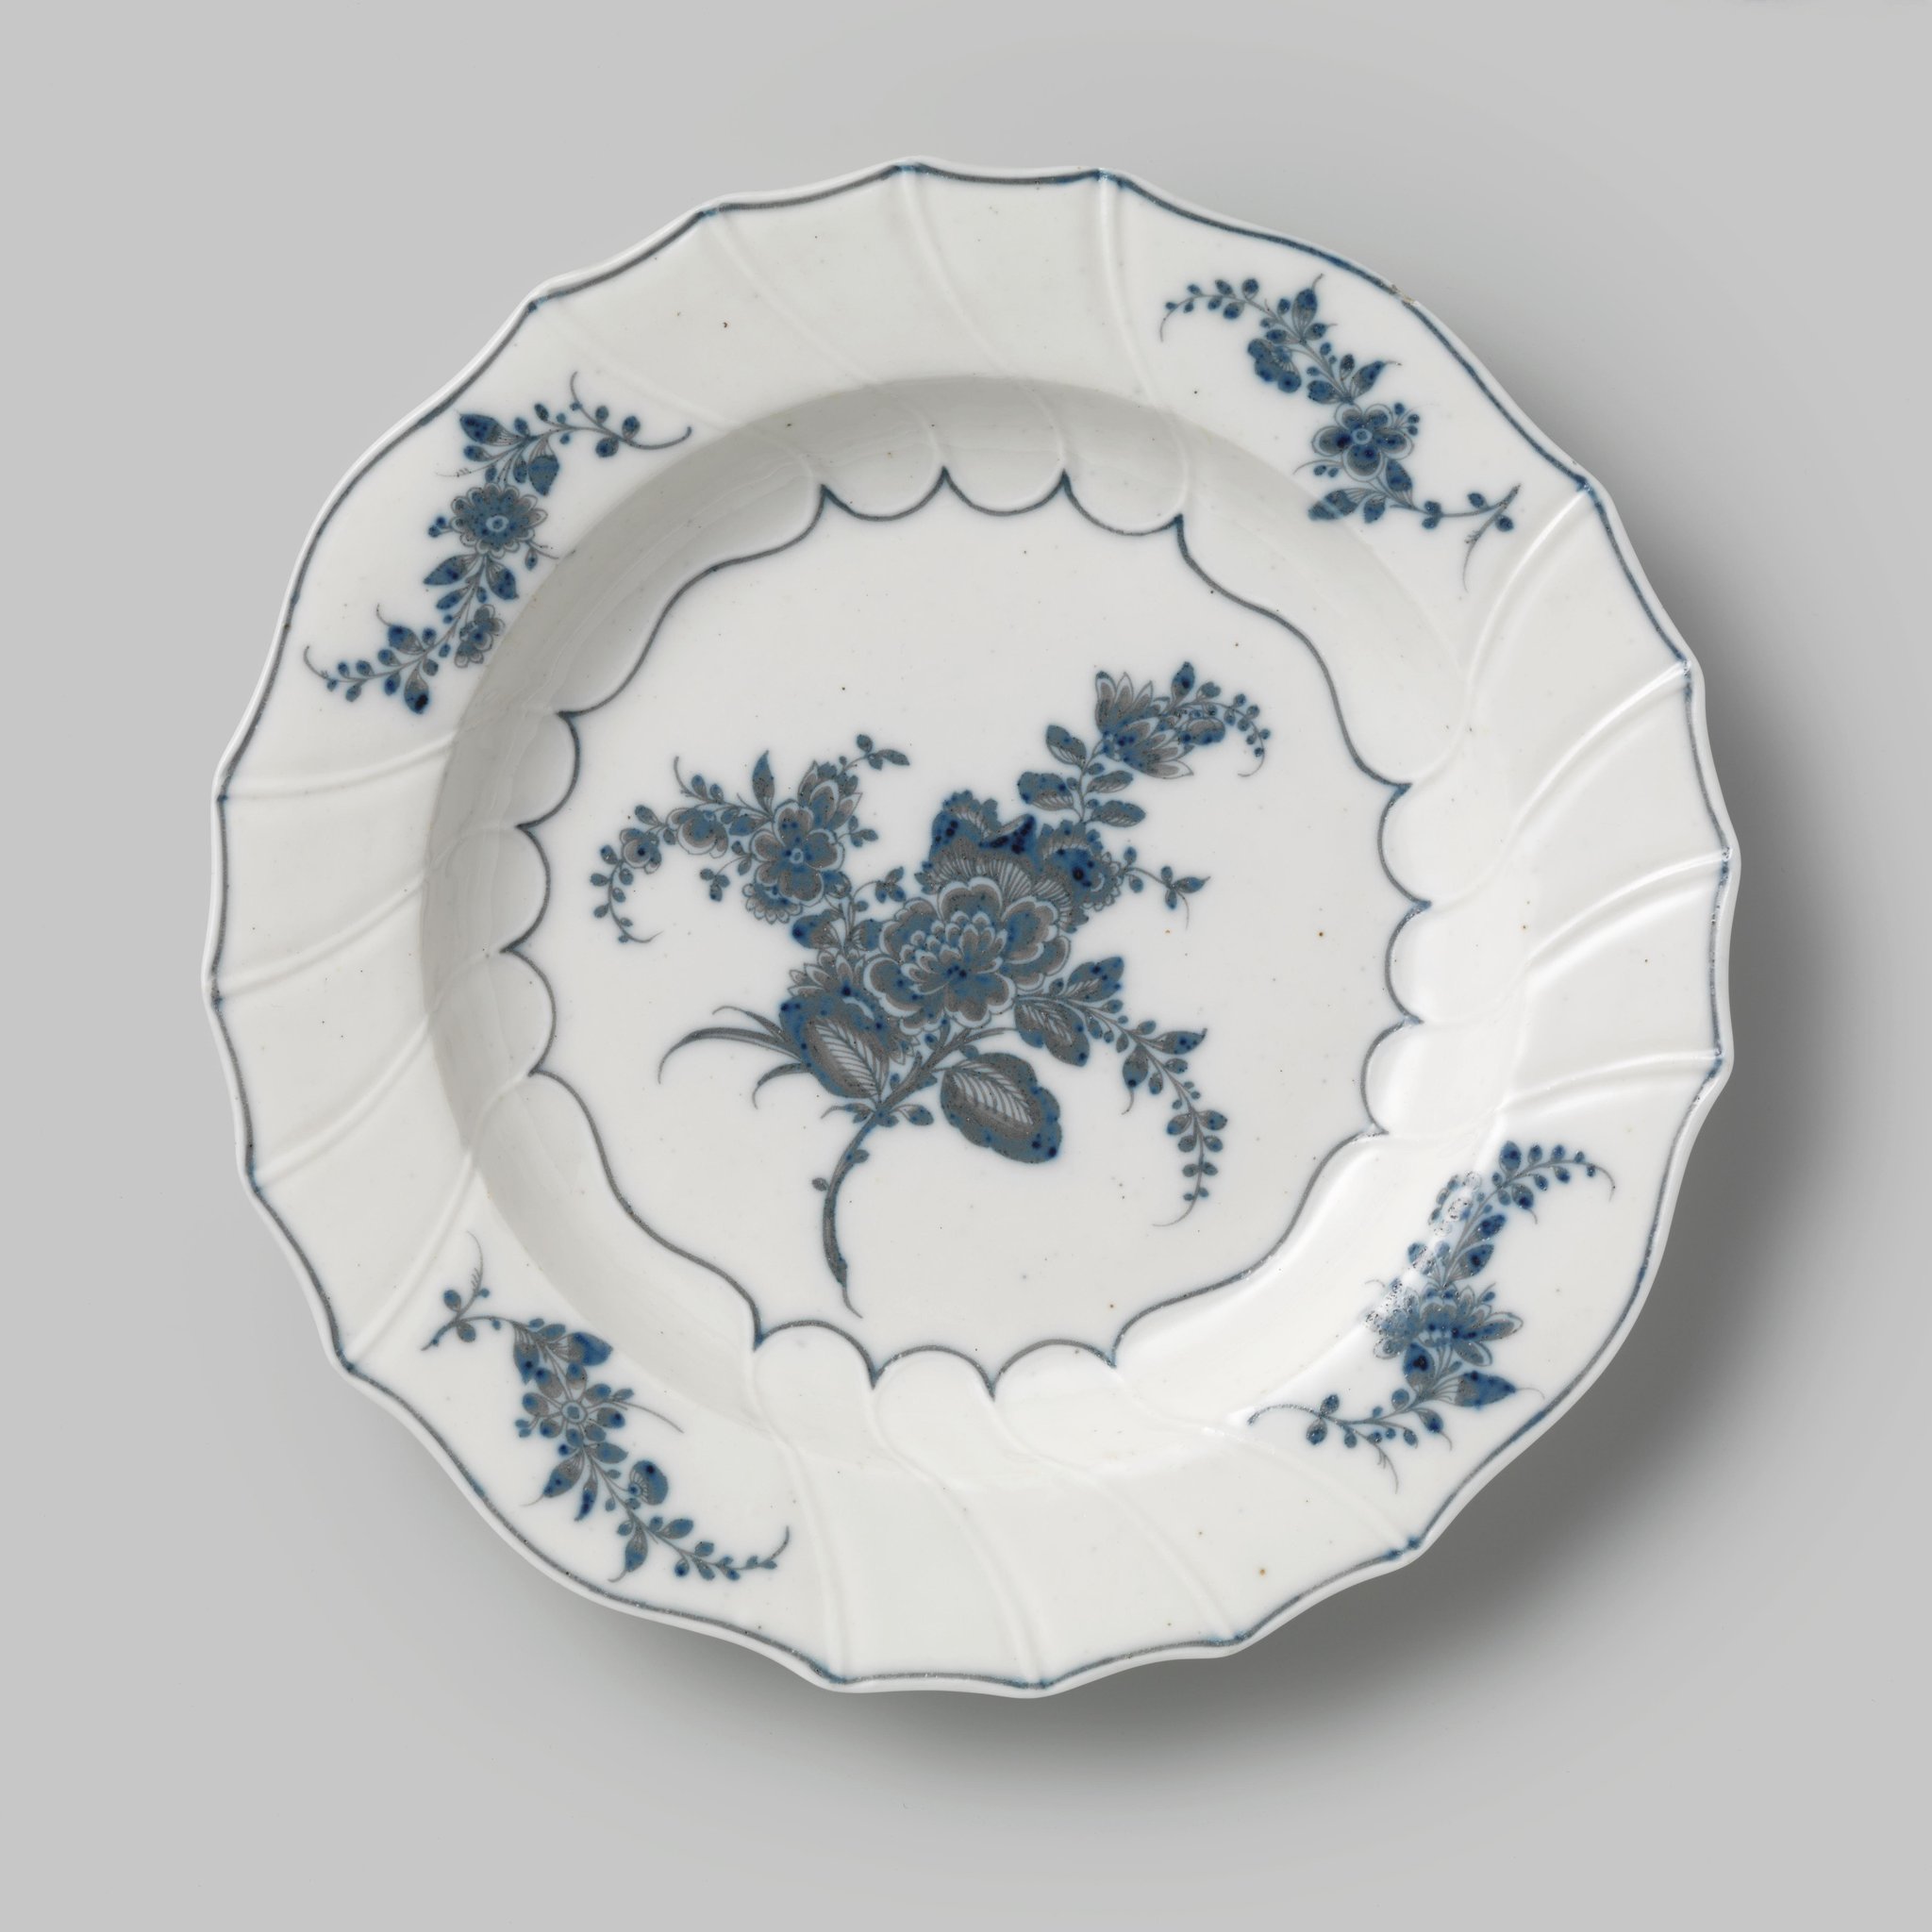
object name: plate dish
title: Bord, beschilderd met bloemtakken en biezen om spiegel en rand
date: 1778-1782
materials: porcelain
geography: loosdrecht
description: Diep bord van porselein. De rand is versierd met getorste ribben in reliëf. Het bord heeft geen voetring en het standvlak is niet geglazuurd. Beschilderd in onderglazuurblauw met bloemtakken. Blauwe biezen om spiegel en rand.